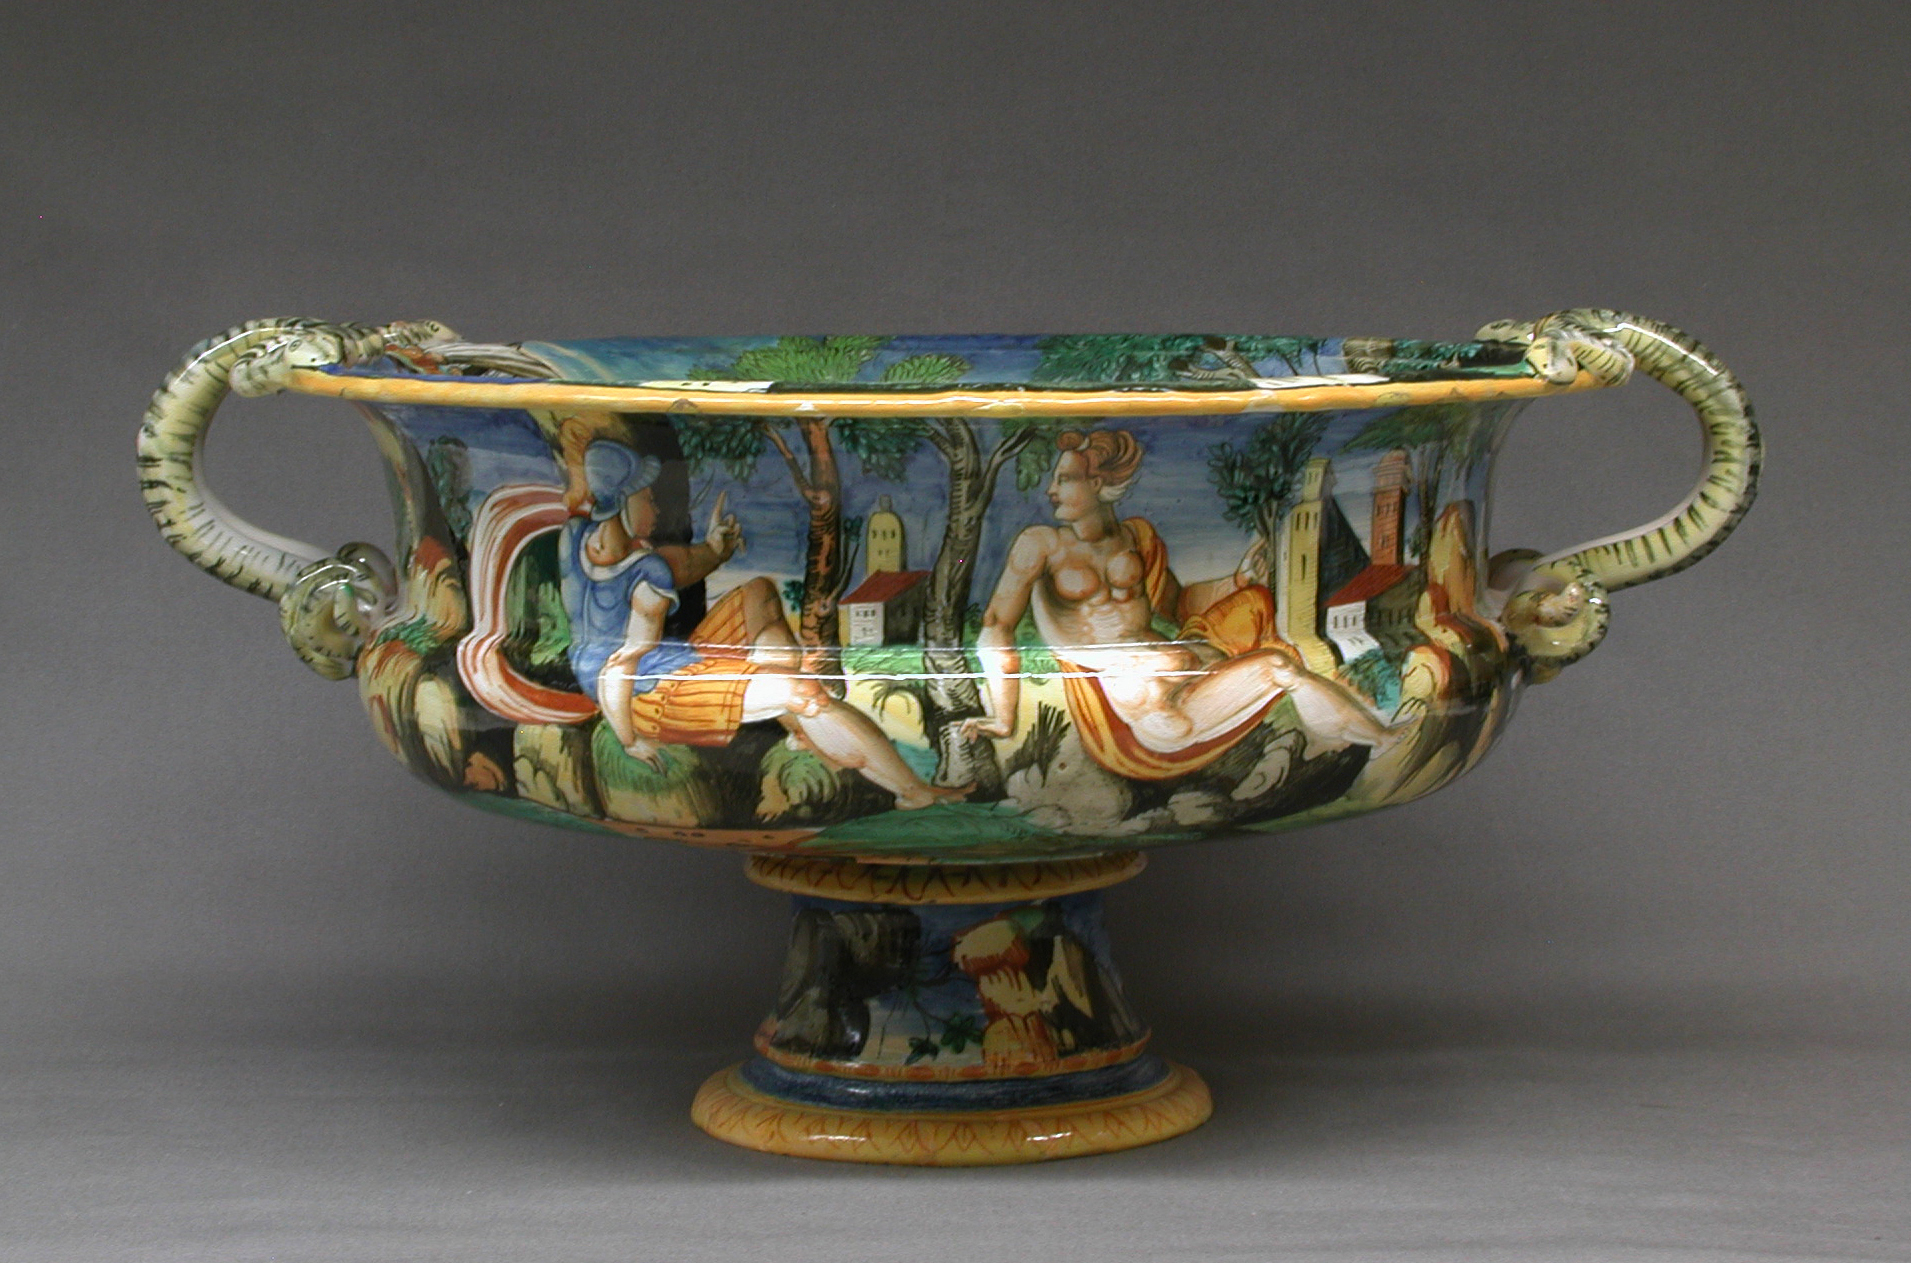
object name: cistern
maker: marcantonio raimondi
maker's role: artist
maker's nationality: italian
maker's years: 1475-1534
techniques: maiolica, glazing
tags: men,male nudes,women,boats